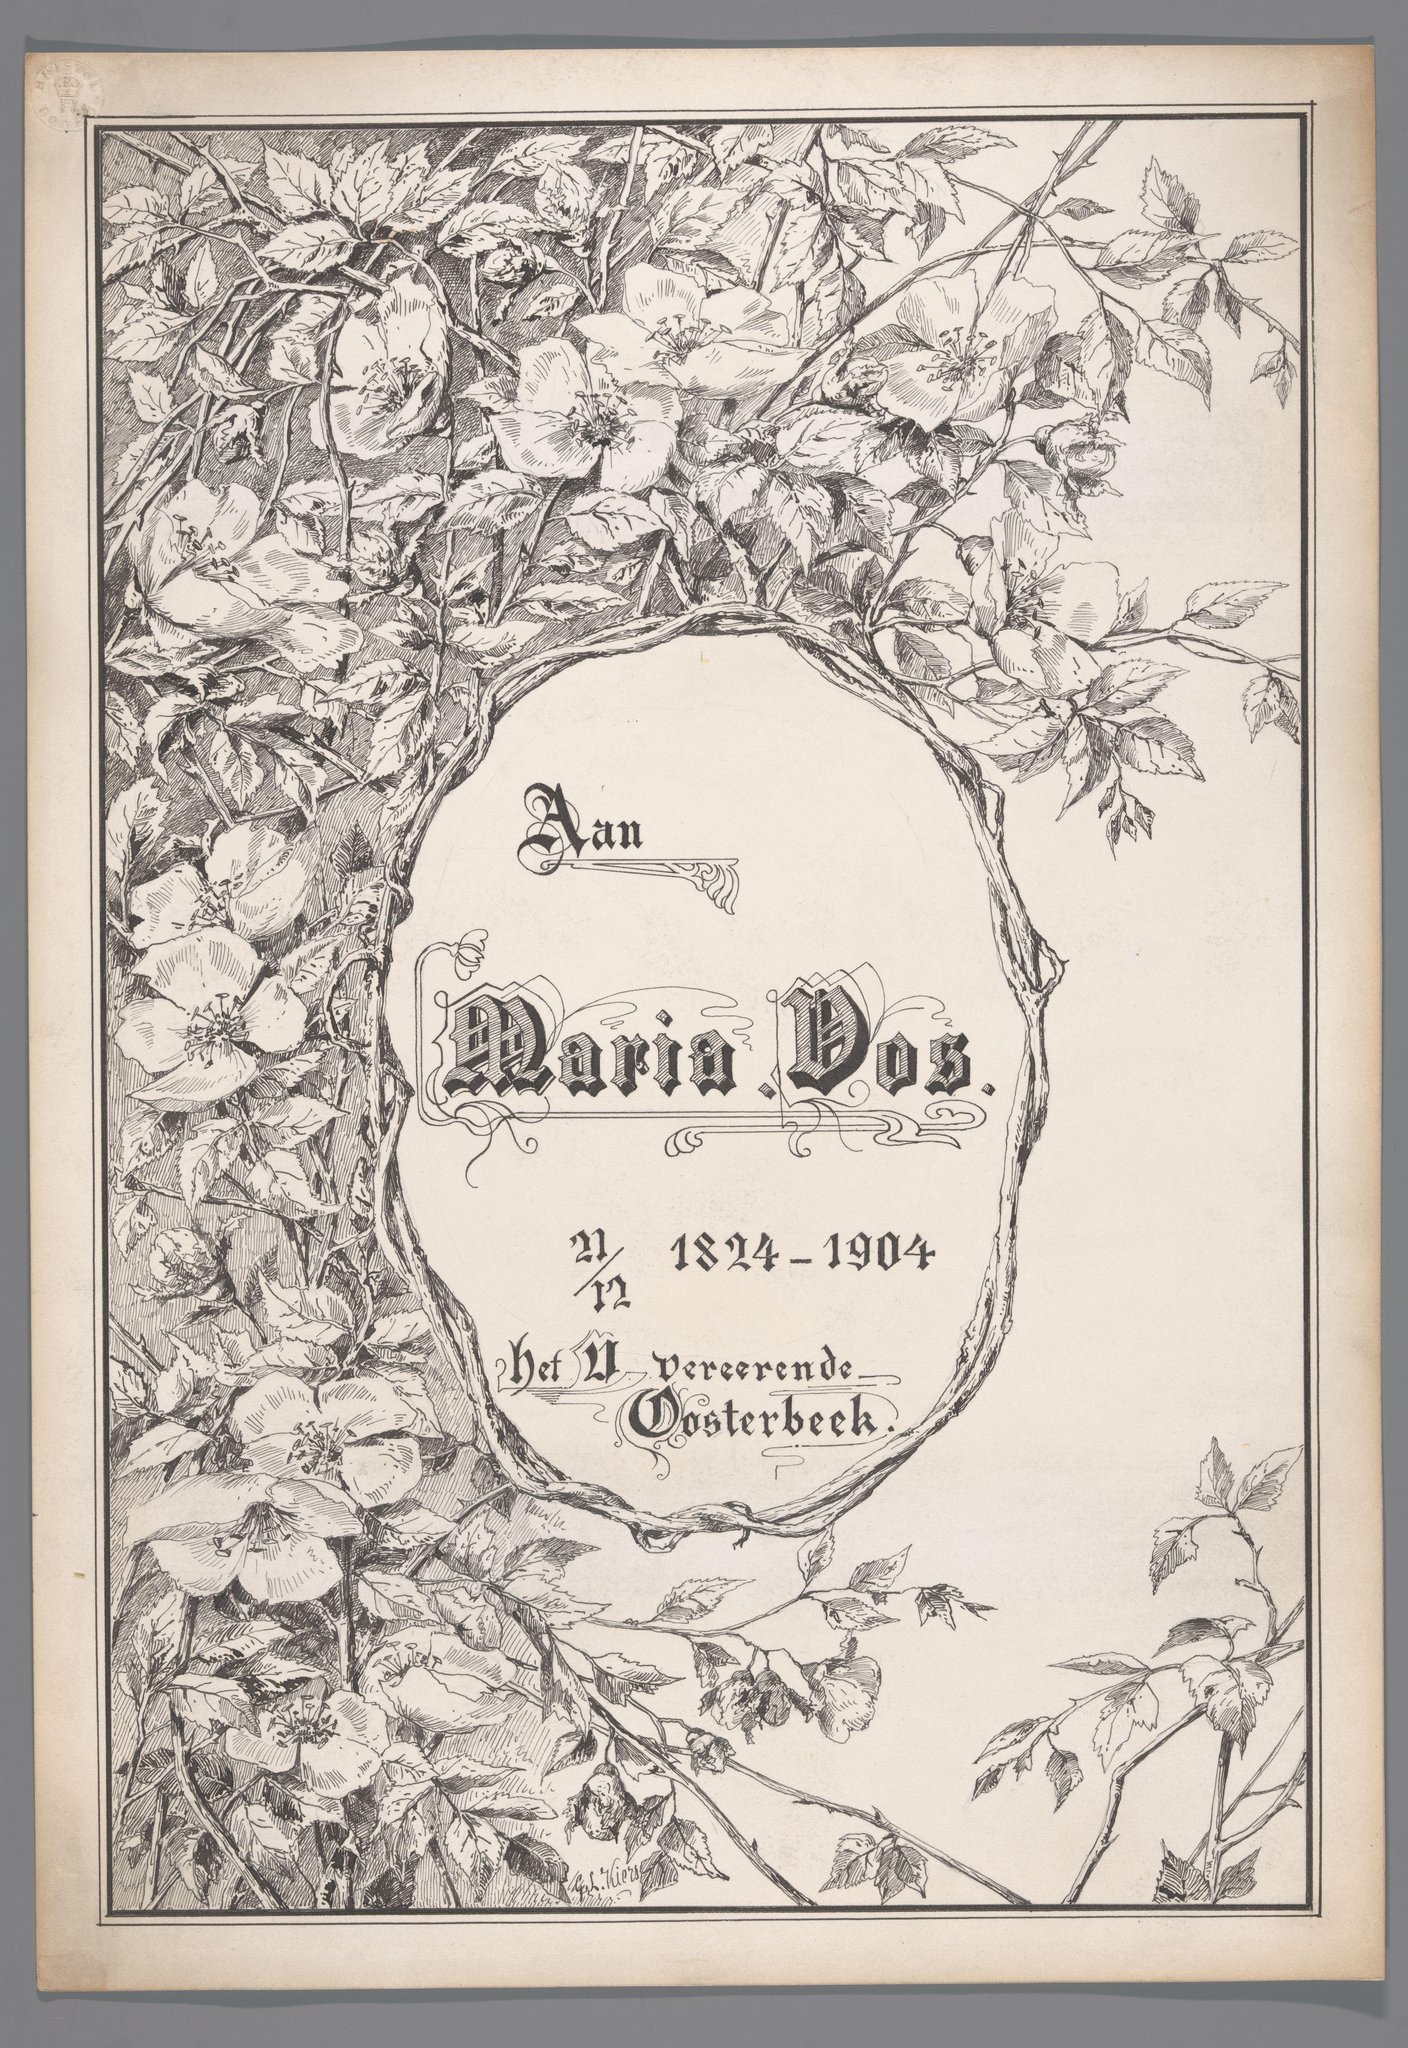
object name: drawing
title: Opdracht aan Maria Vos omringd door een bloemenstruik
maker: george lourens kiers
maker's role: draughtsman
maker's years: 1838-1916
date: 1904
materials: ink, paper, pencil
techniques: pen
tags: painter, print maker, draughtsman, maria vos, flowers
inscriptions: date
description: Opdracht aan Maria Vos ter ere van haar tachtigjarige verjaardag, opgedragen namens inwoners van Oosterbeek, Gelderland.